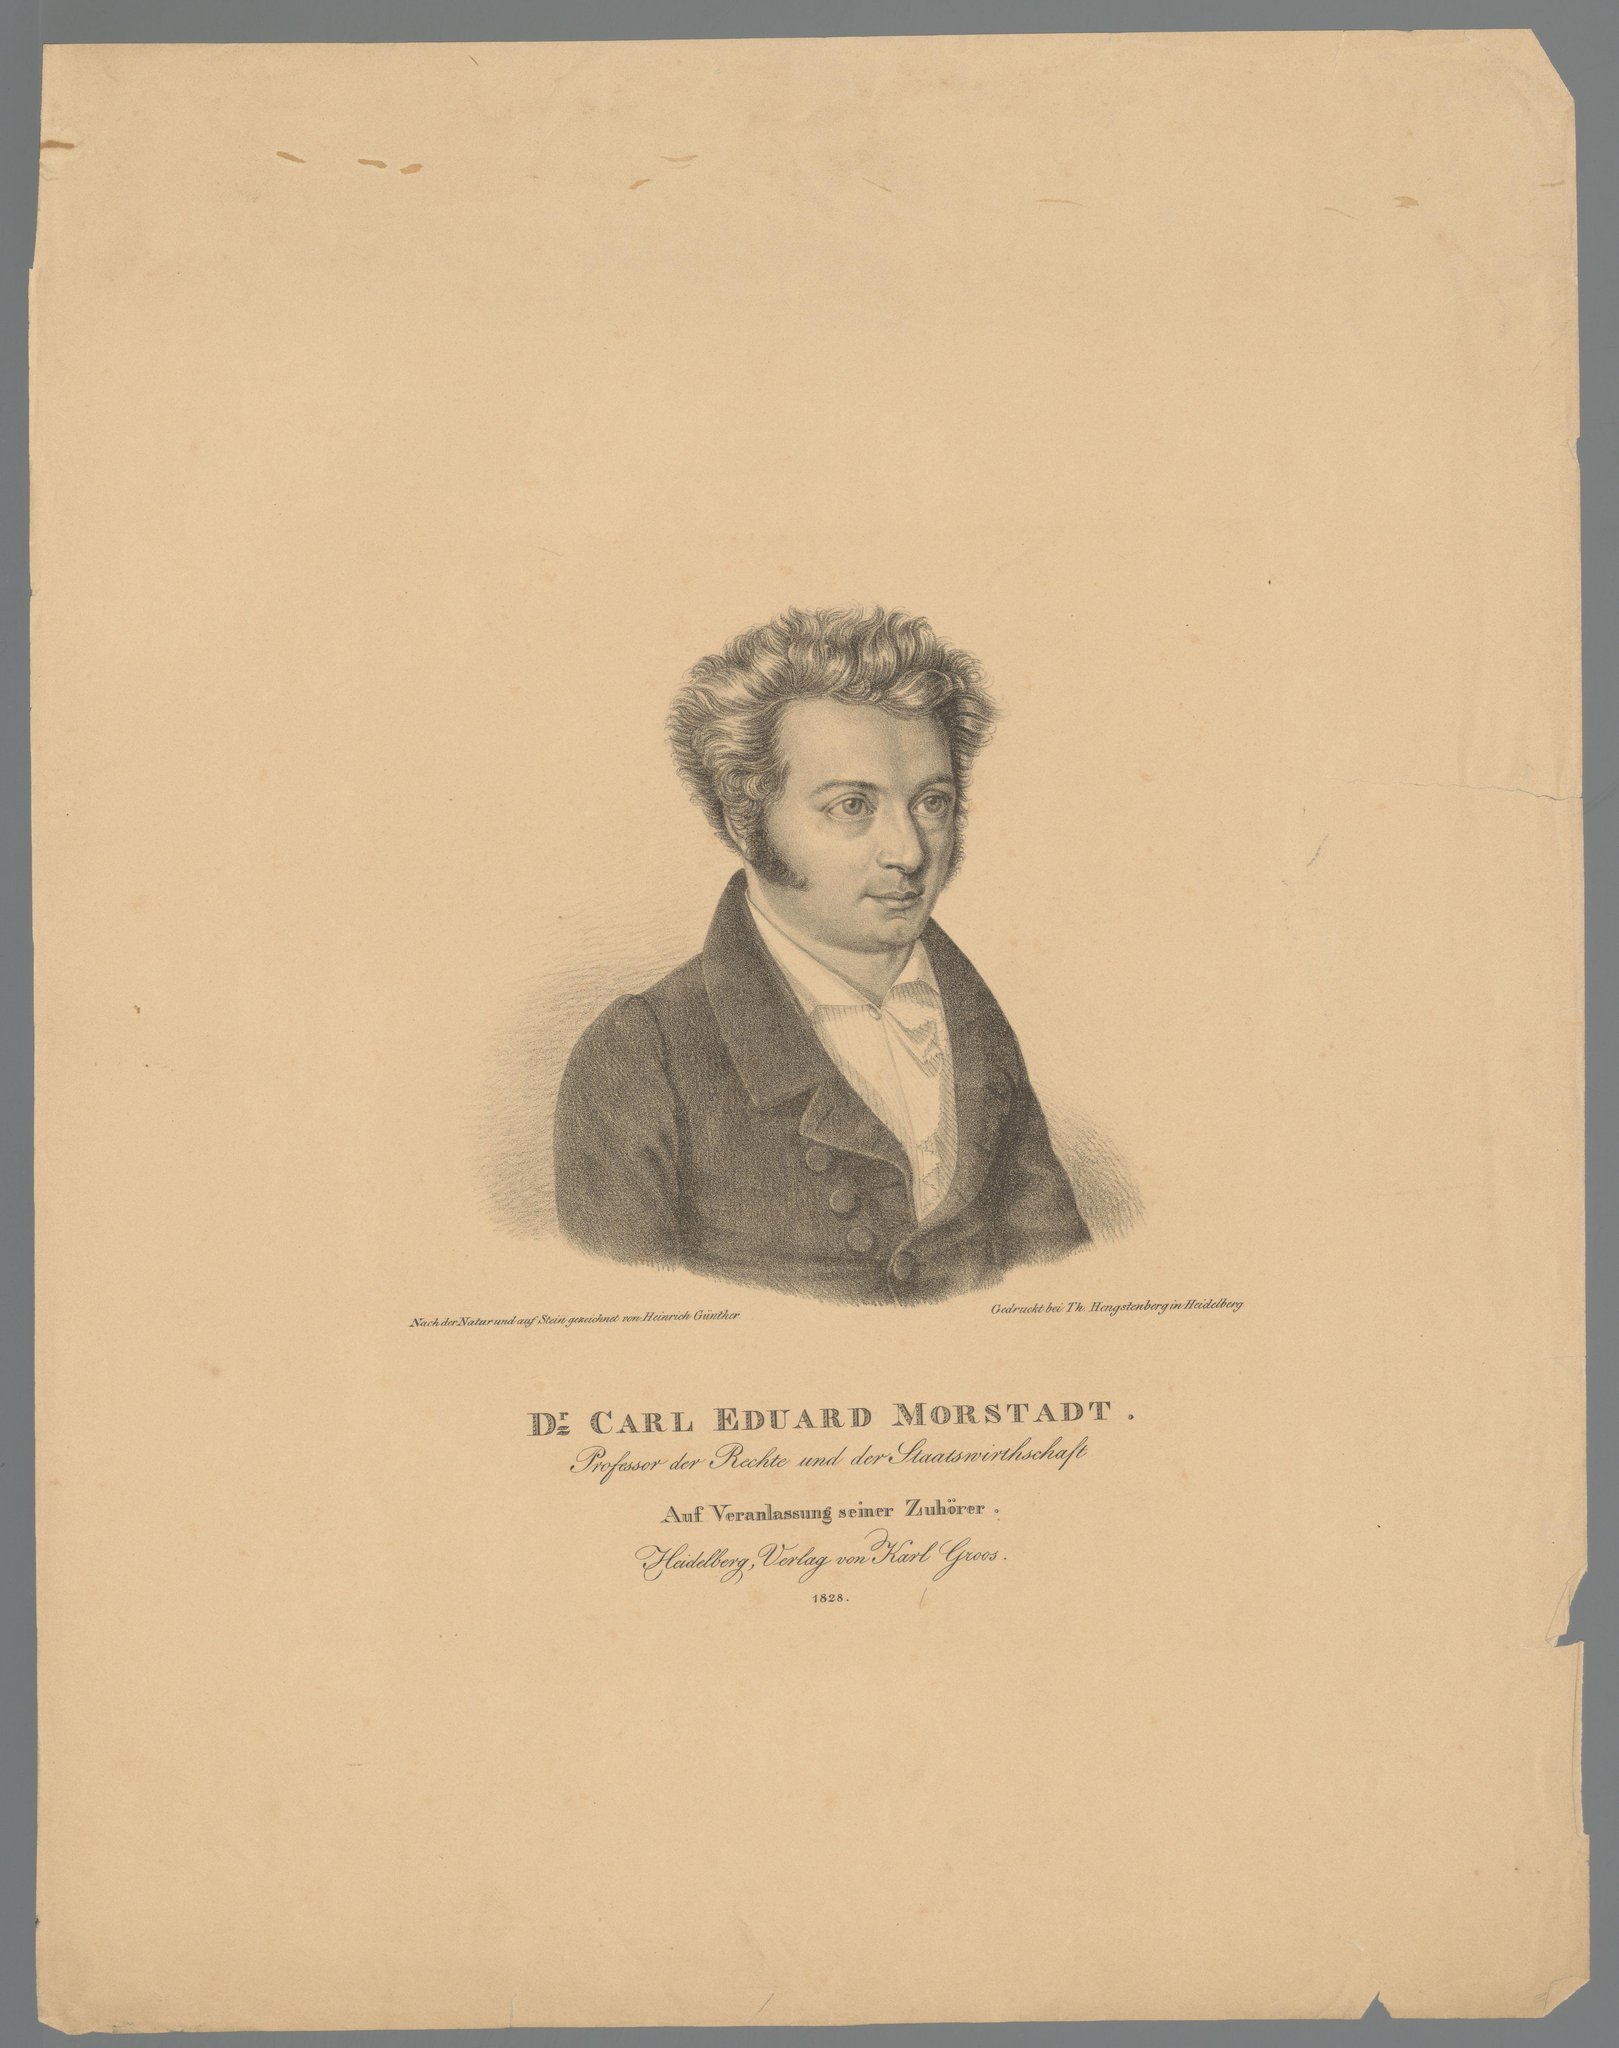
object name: print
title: Dr. Carl Eduard Morstadt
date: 1828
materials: paper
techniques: lithograph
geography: heidelberg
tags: adult man, historical persons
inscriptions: collector's mark: Lugt 2228